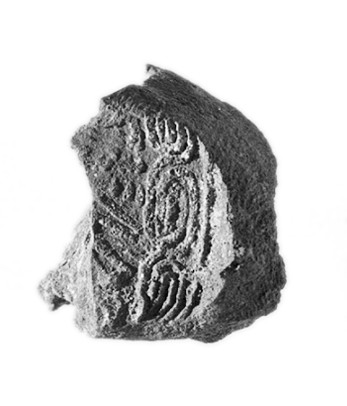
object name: sealing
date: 1981-1640 BCE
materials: mud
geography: egypt